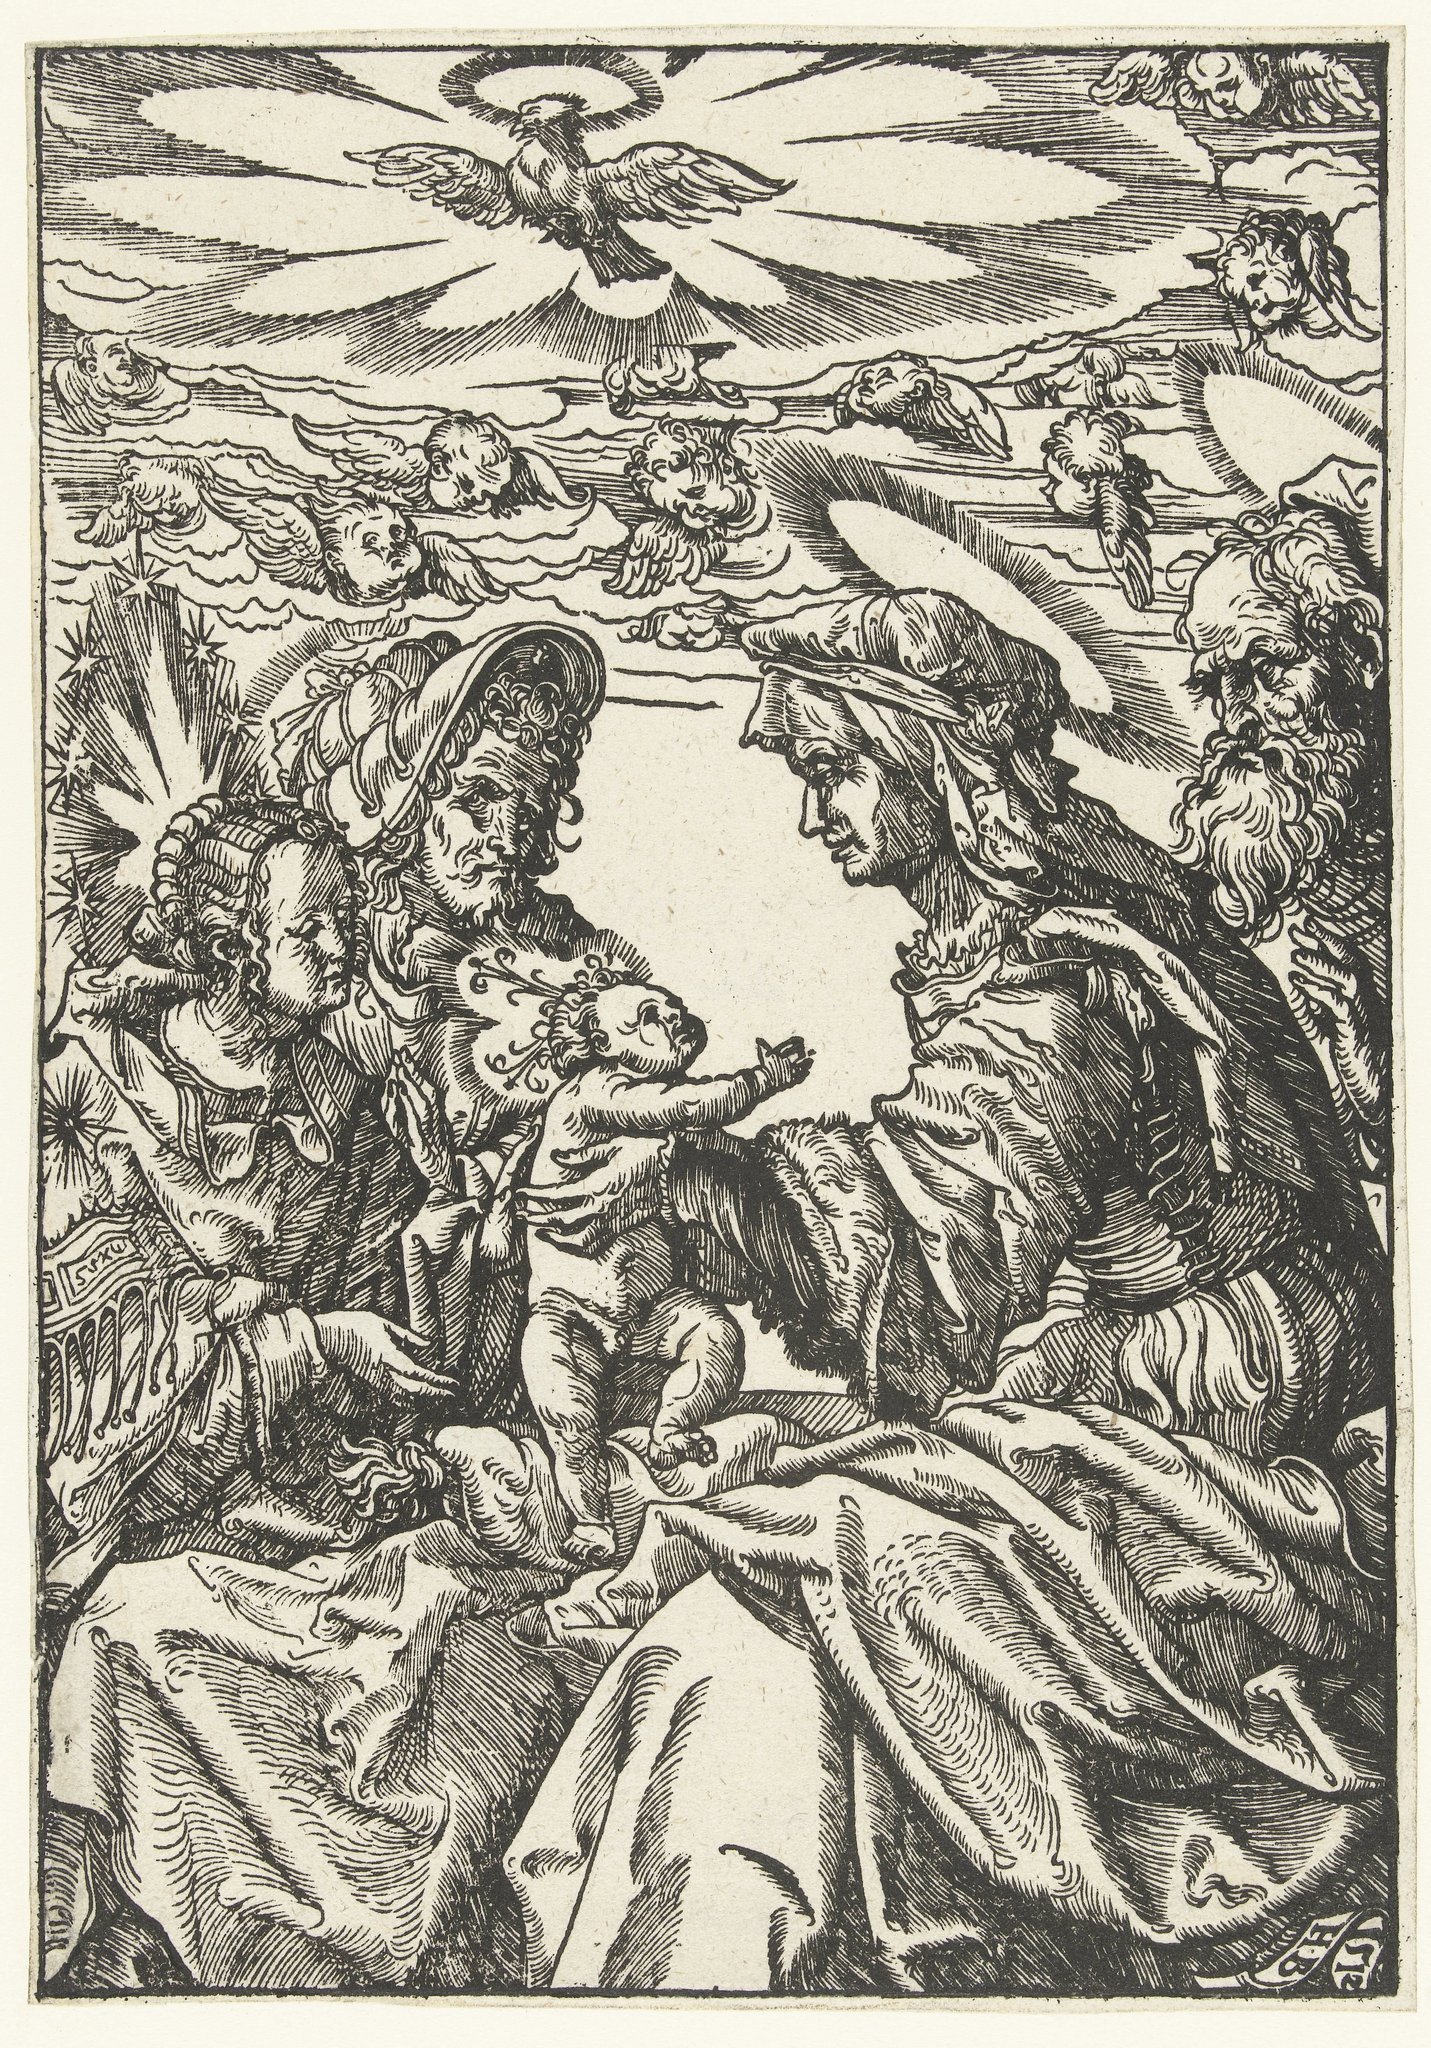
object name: print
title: Anna te drieën met Jozef en Joachim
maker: hans burgkmair (i)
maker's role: draughtsman, print maker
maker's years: 1473-1531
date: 1512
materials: paper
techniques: woodcut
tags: 'anna selbdritt' with joseph and joachim present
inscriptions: collector's mark: Lugt 2228a, collector's mark: Lugt 305, collector's mark: Lugt 300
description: Anna neemt het Christuskind in haar armen van Maria's schoot terwijl Jozef en Joachim toekijken. In de hemel zweeft de duif als symbool van de heilige Geest omringd door engelenkopjes.